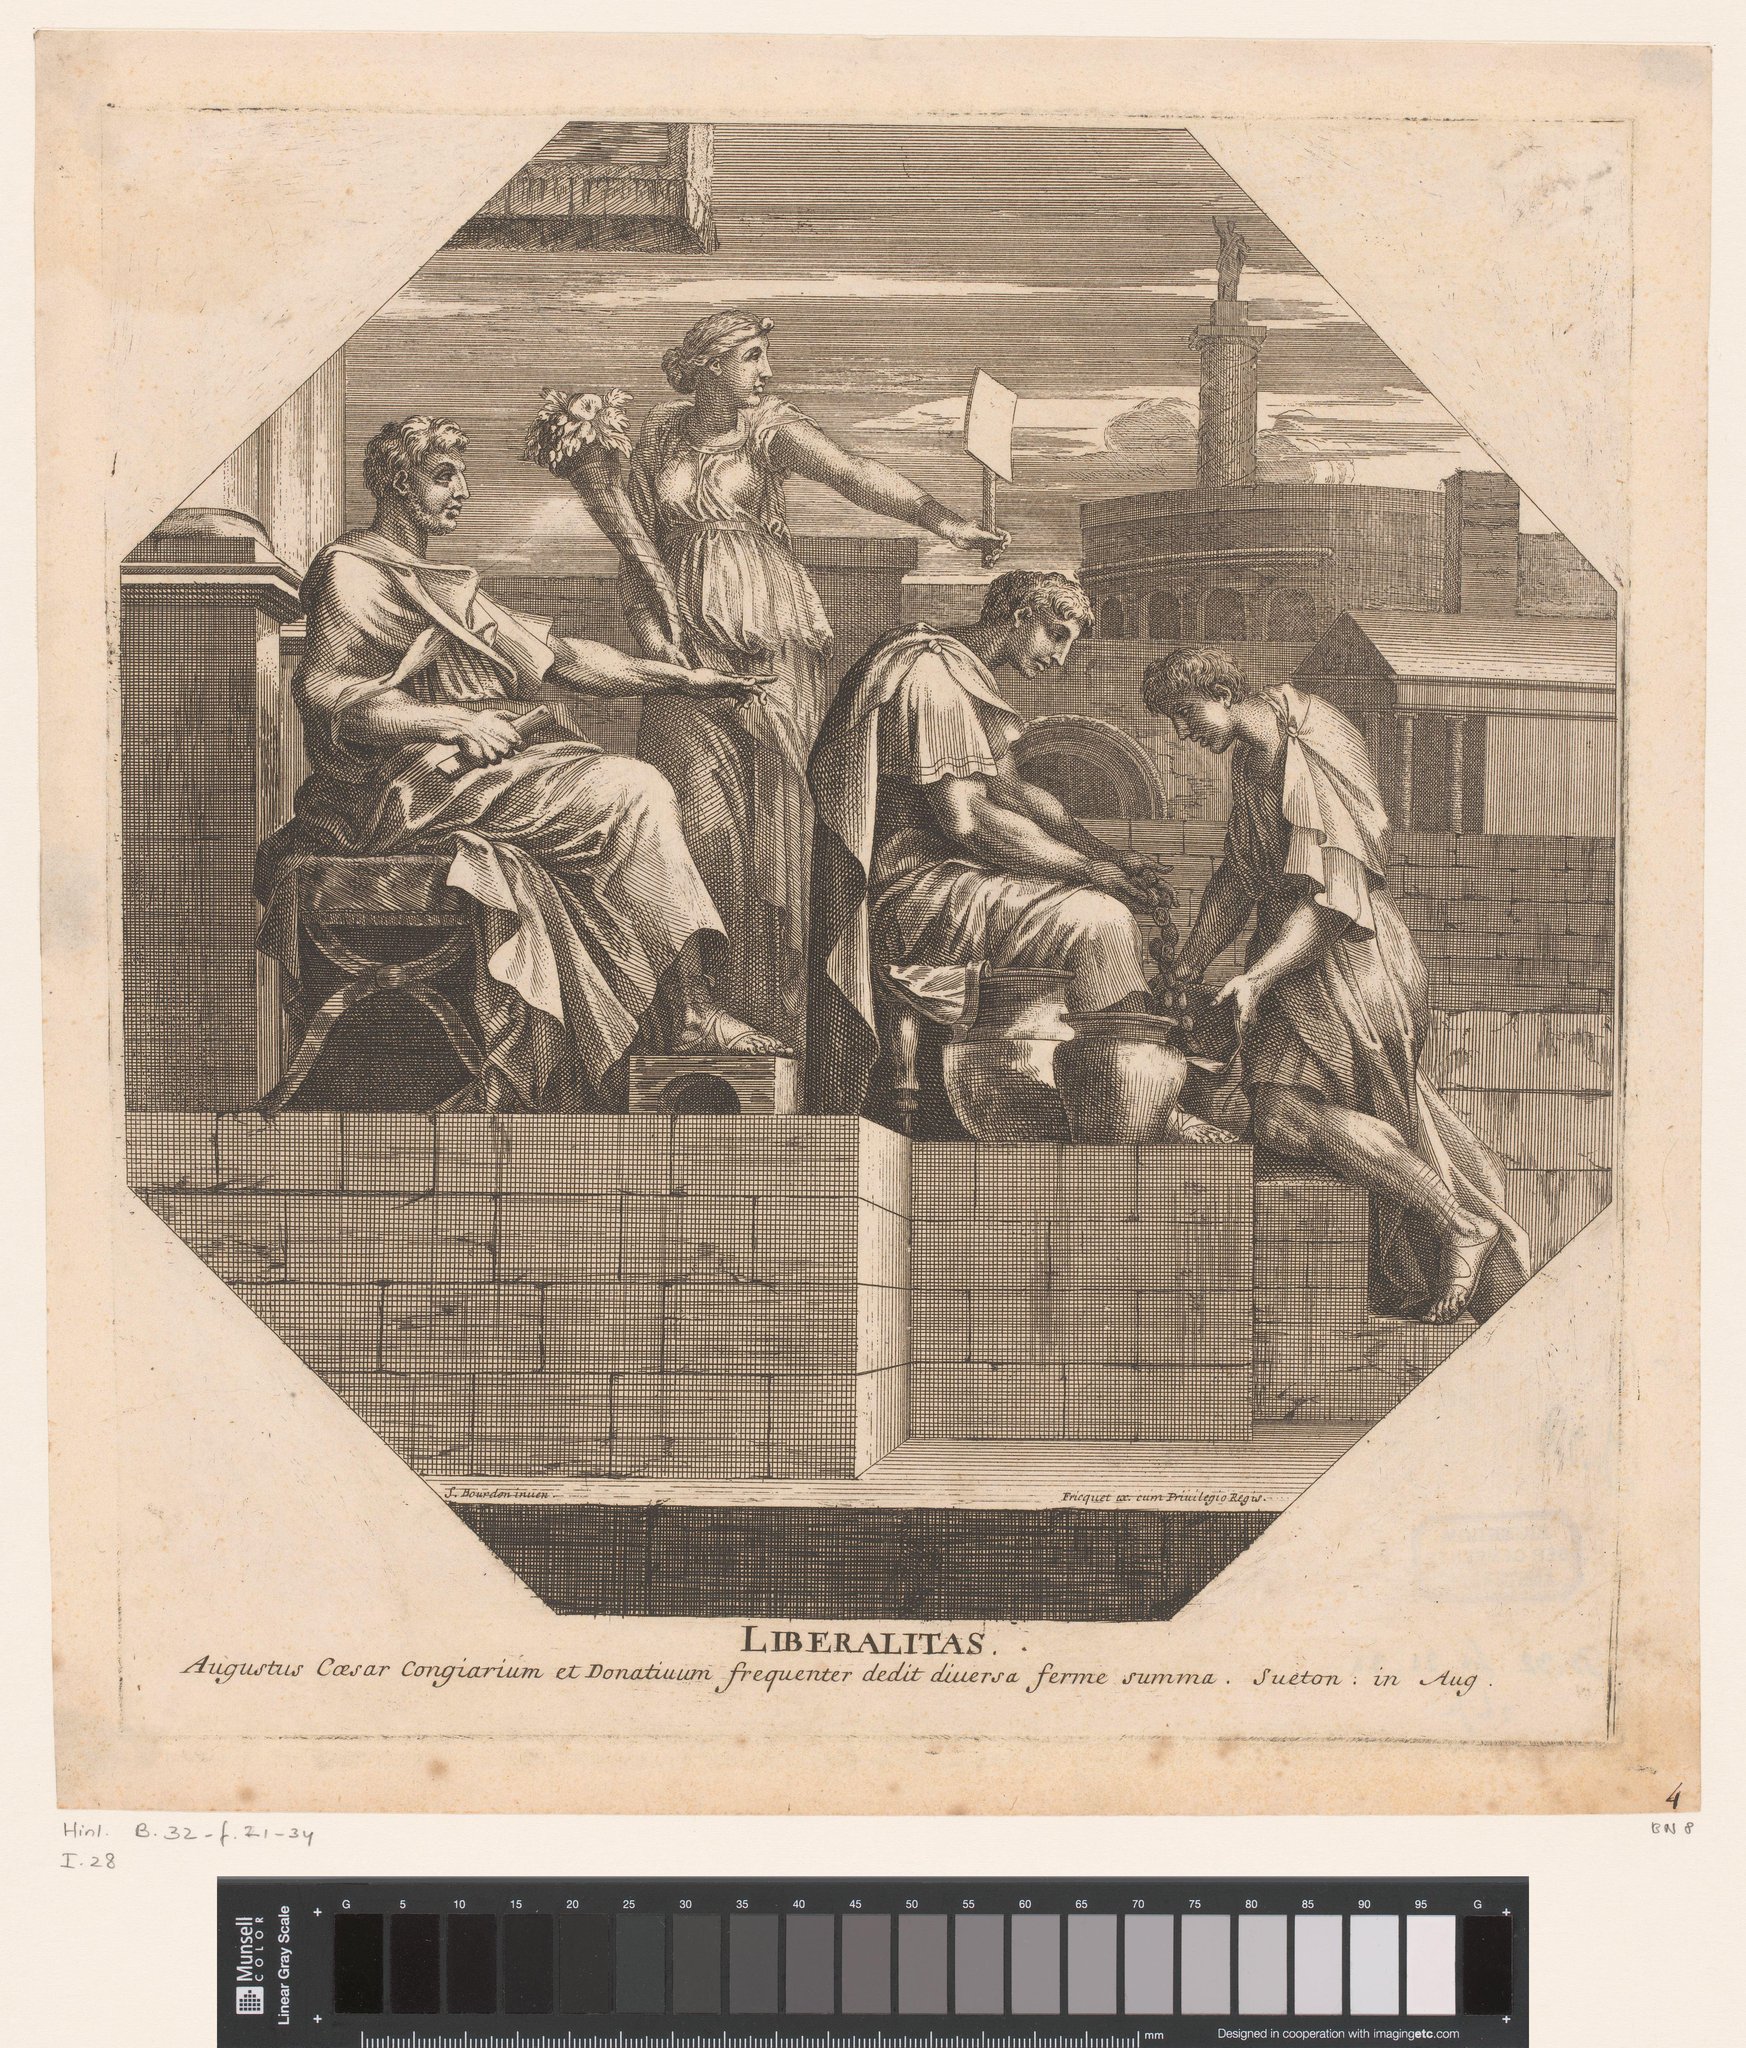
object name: print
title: Les Vertus et les Arts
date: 1663-1716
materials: paper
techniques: engraving, etching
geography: france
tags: historical persons, generosity, liberality; 'generosità', 'liberalità' (ripa)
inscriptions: number: ‘4’, collector's mark: Lugt 11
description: Maakt deel uit van een veertiendelige serie opgedeeld in twee reeksen, met als onderwerp de zeven vrije kunsten en deugden naar schilderijen door Sébastien Bourdon. De schilderijen werden in 1663 vervaardigd voor de Grande Galerie van het Hôtel de Bretonvilliers te Parijs.